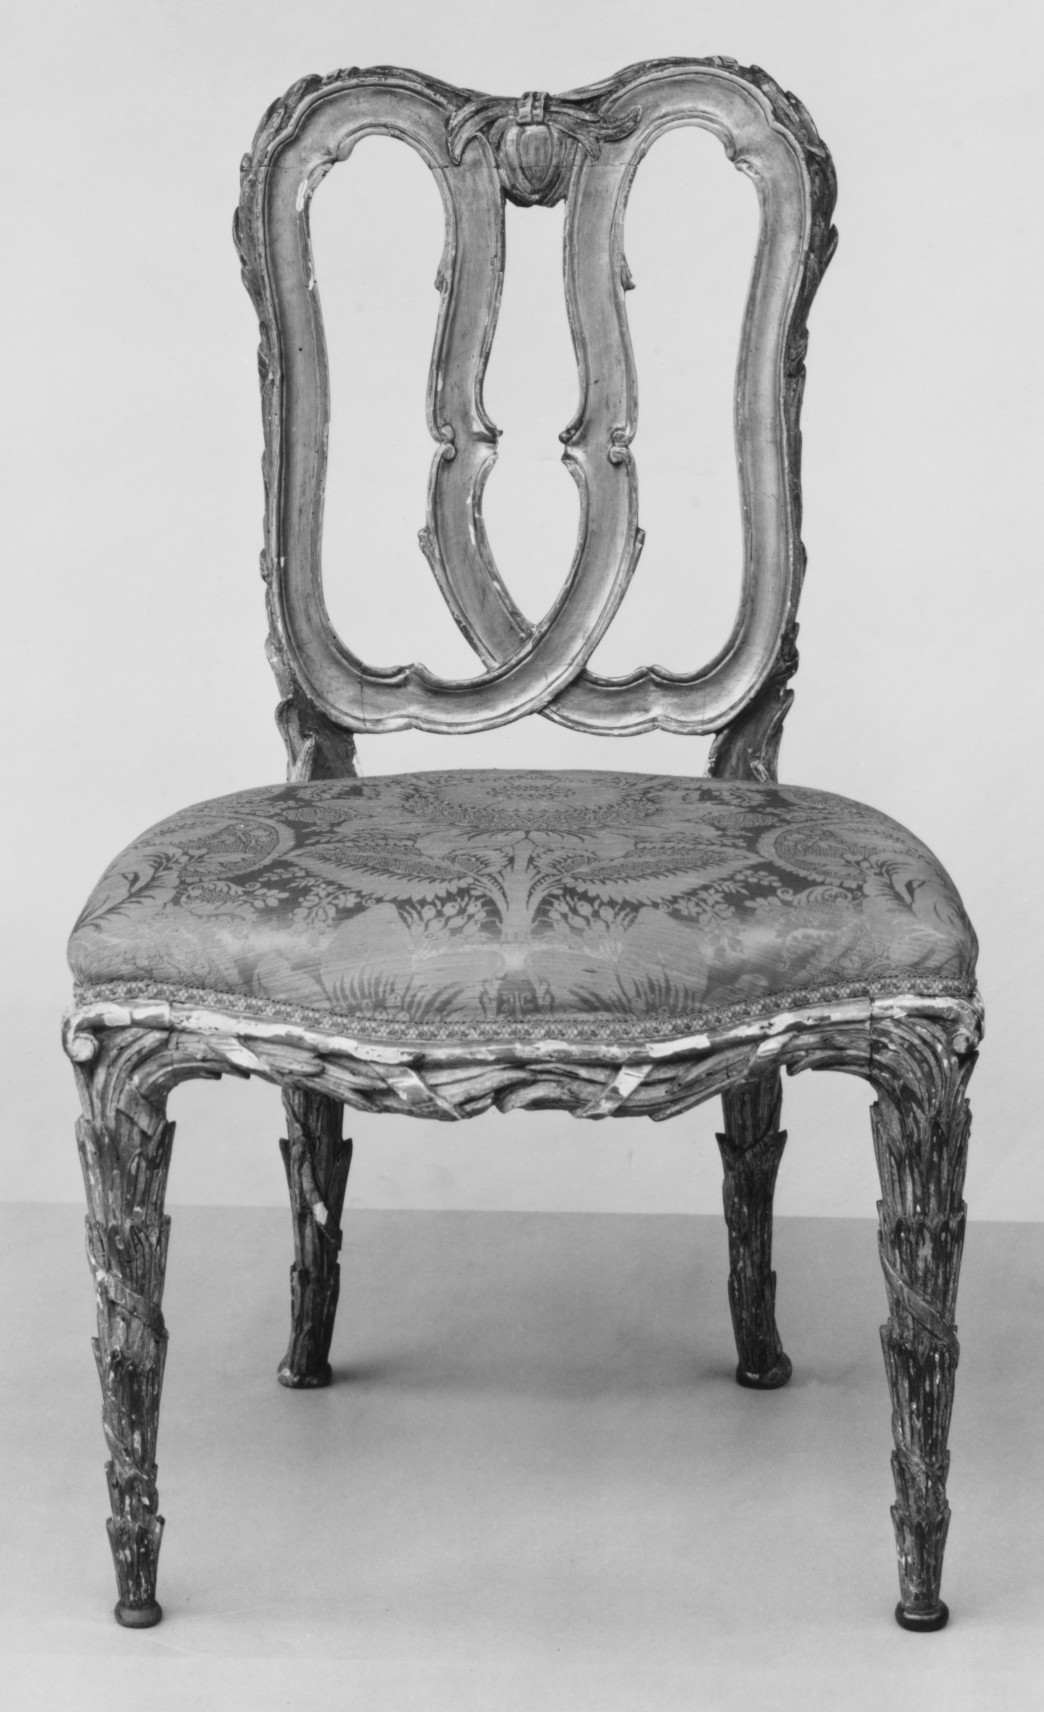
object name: side chair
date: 1751-1775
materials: wood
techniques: damask, gilding, painting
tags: flowers